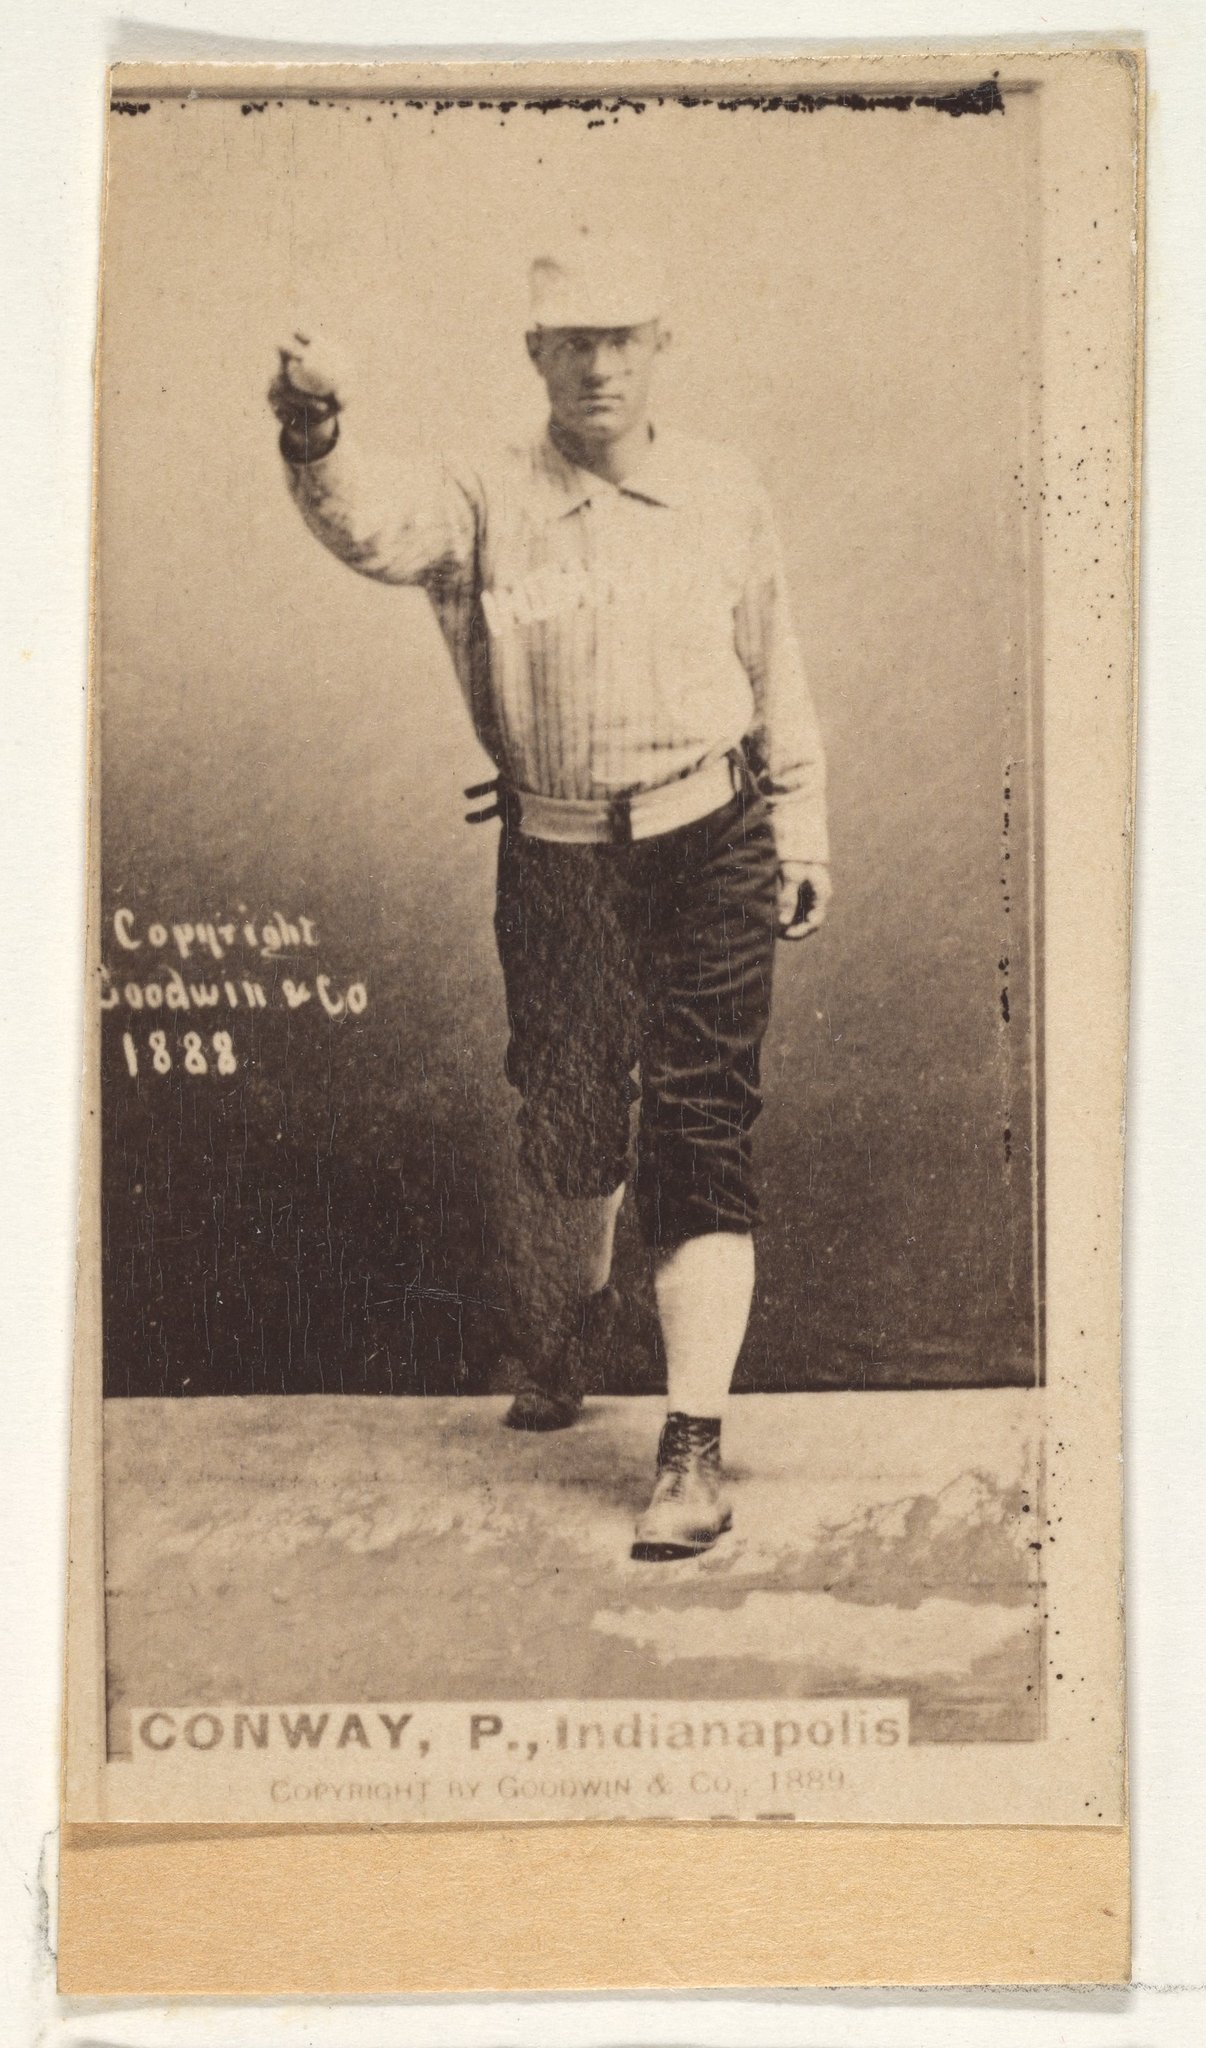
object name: baseball card, photograph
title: Conway, Pitcher, Indianapolis, from the Old Judge series (N172) for Old Judge Cigarettes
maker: goodwin & company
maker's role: publisher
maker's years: 1850-1950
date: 1889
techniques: albumen silver print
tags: men,portraits,baseball,athletes